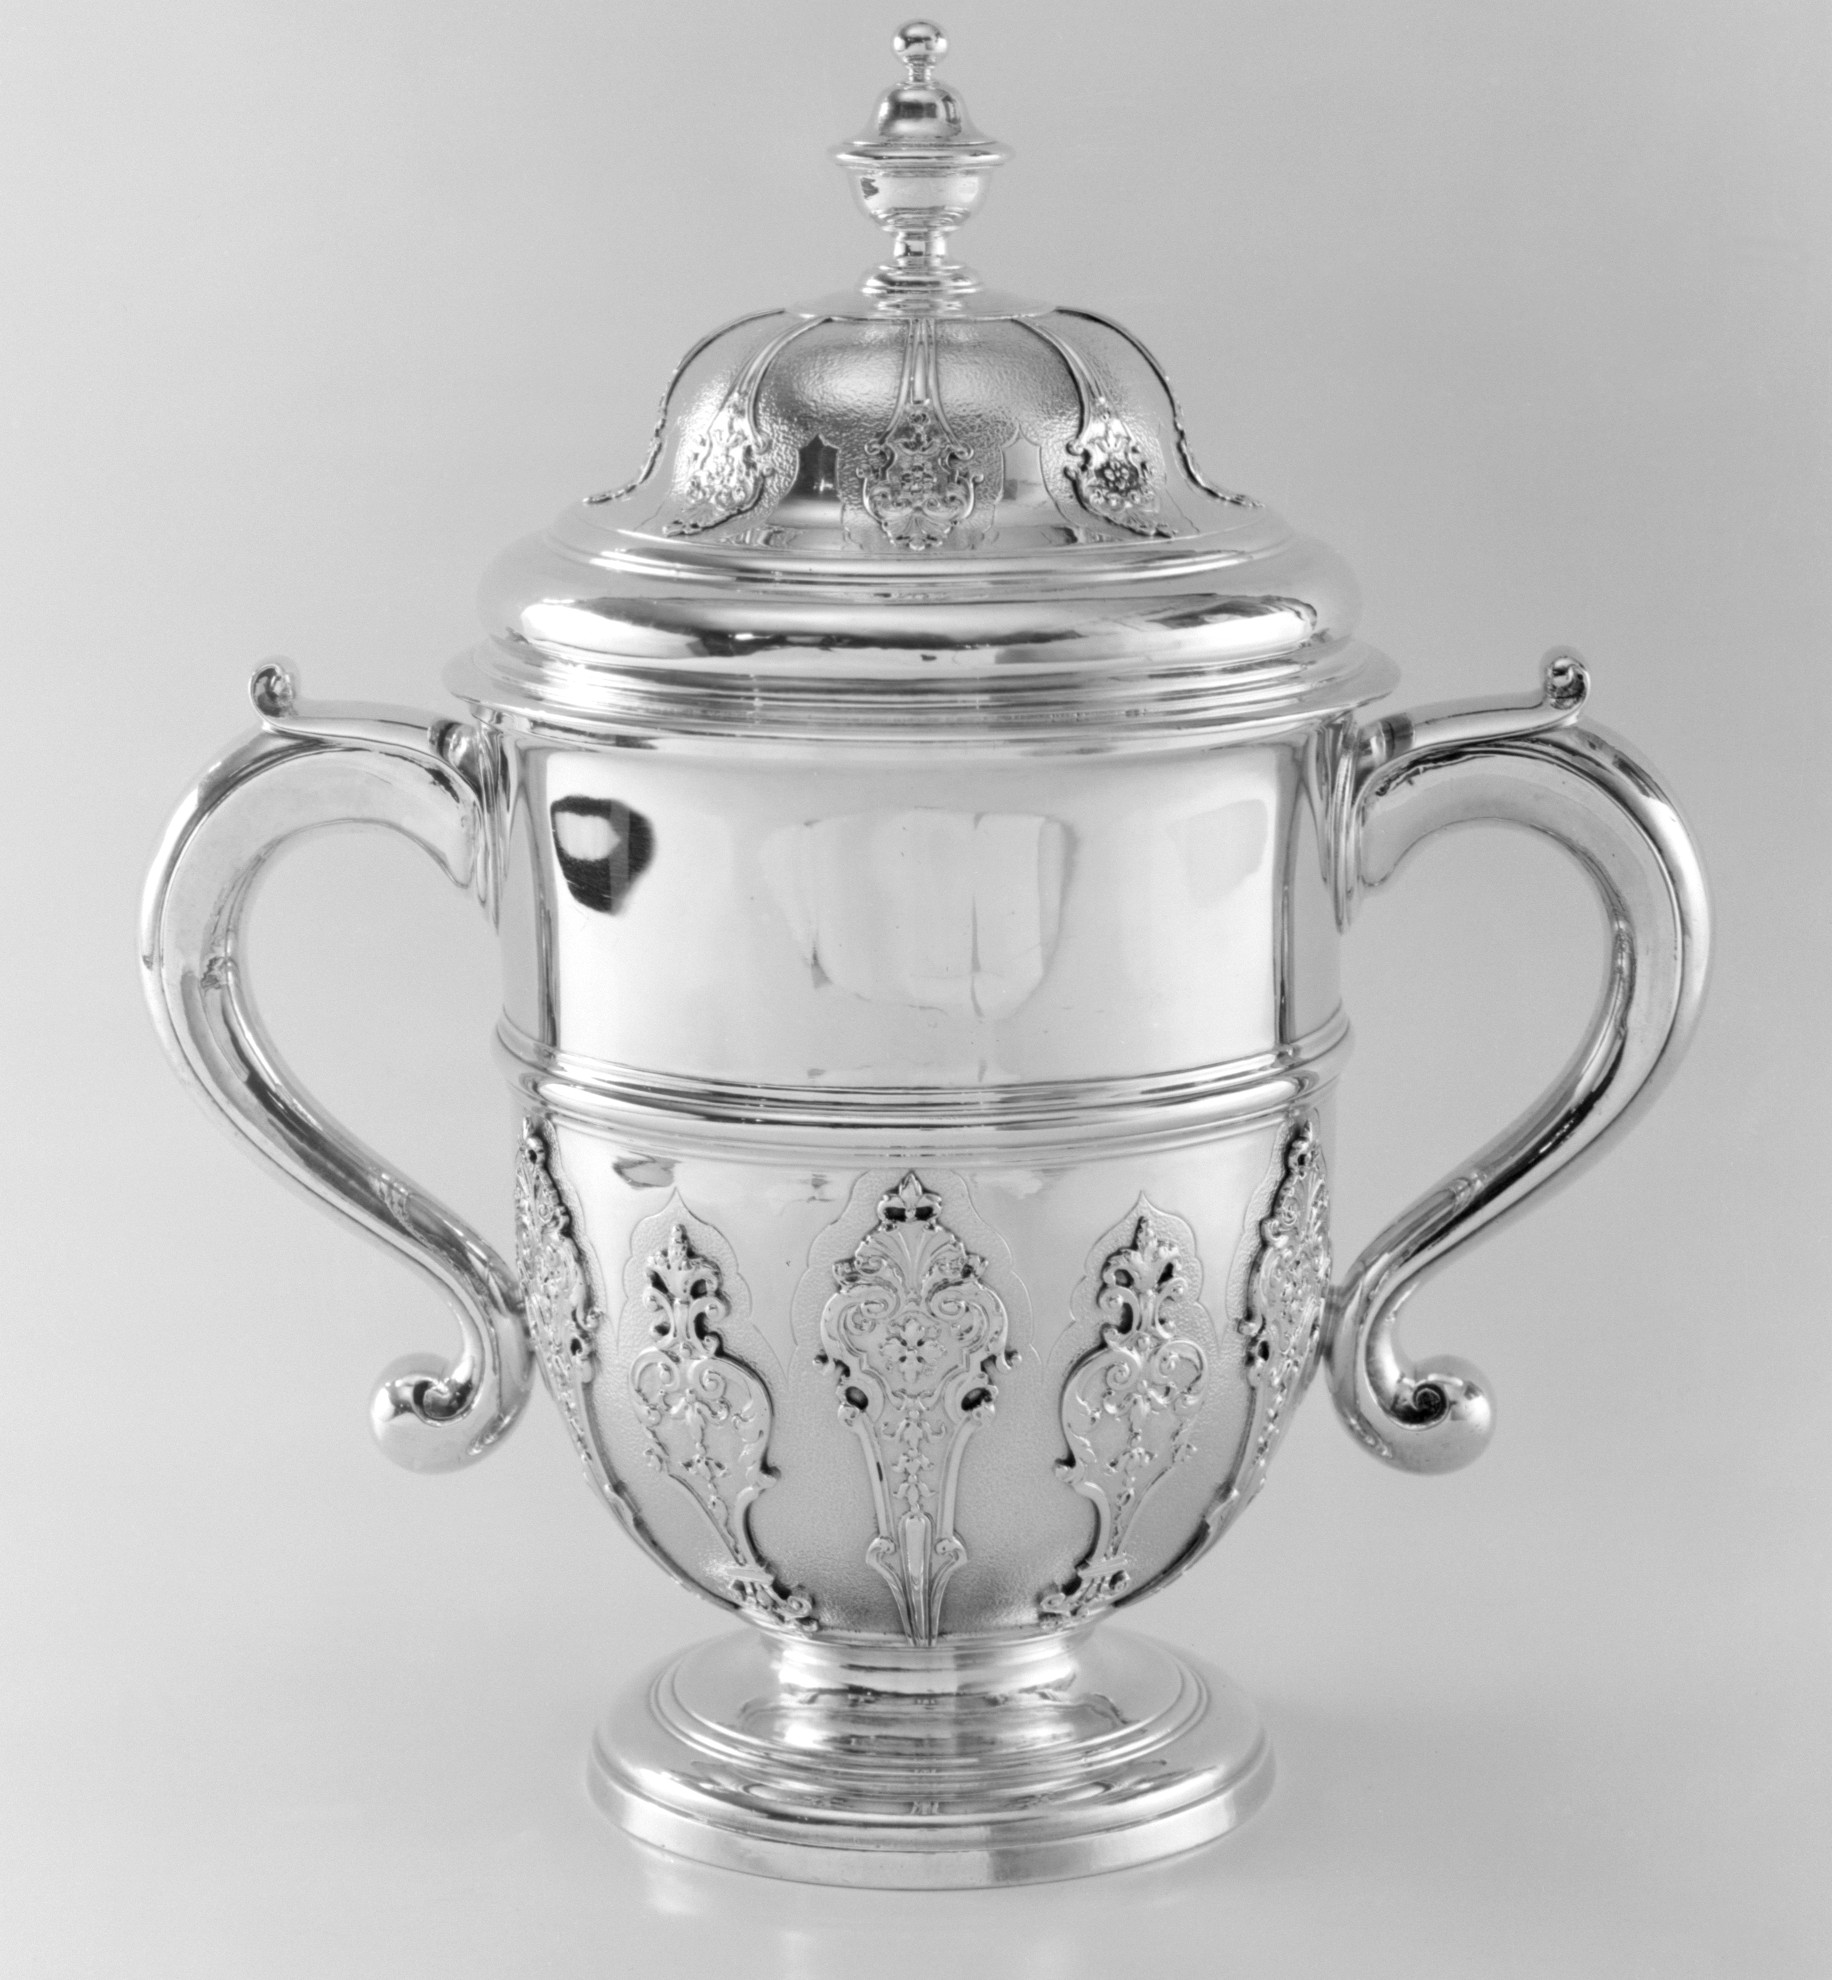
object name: cup with cover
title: Two-handled cup with cover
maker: augustin courtauld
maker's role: maker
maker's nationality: british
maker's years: 1685-1751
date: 1718-1720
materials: gilt, silver